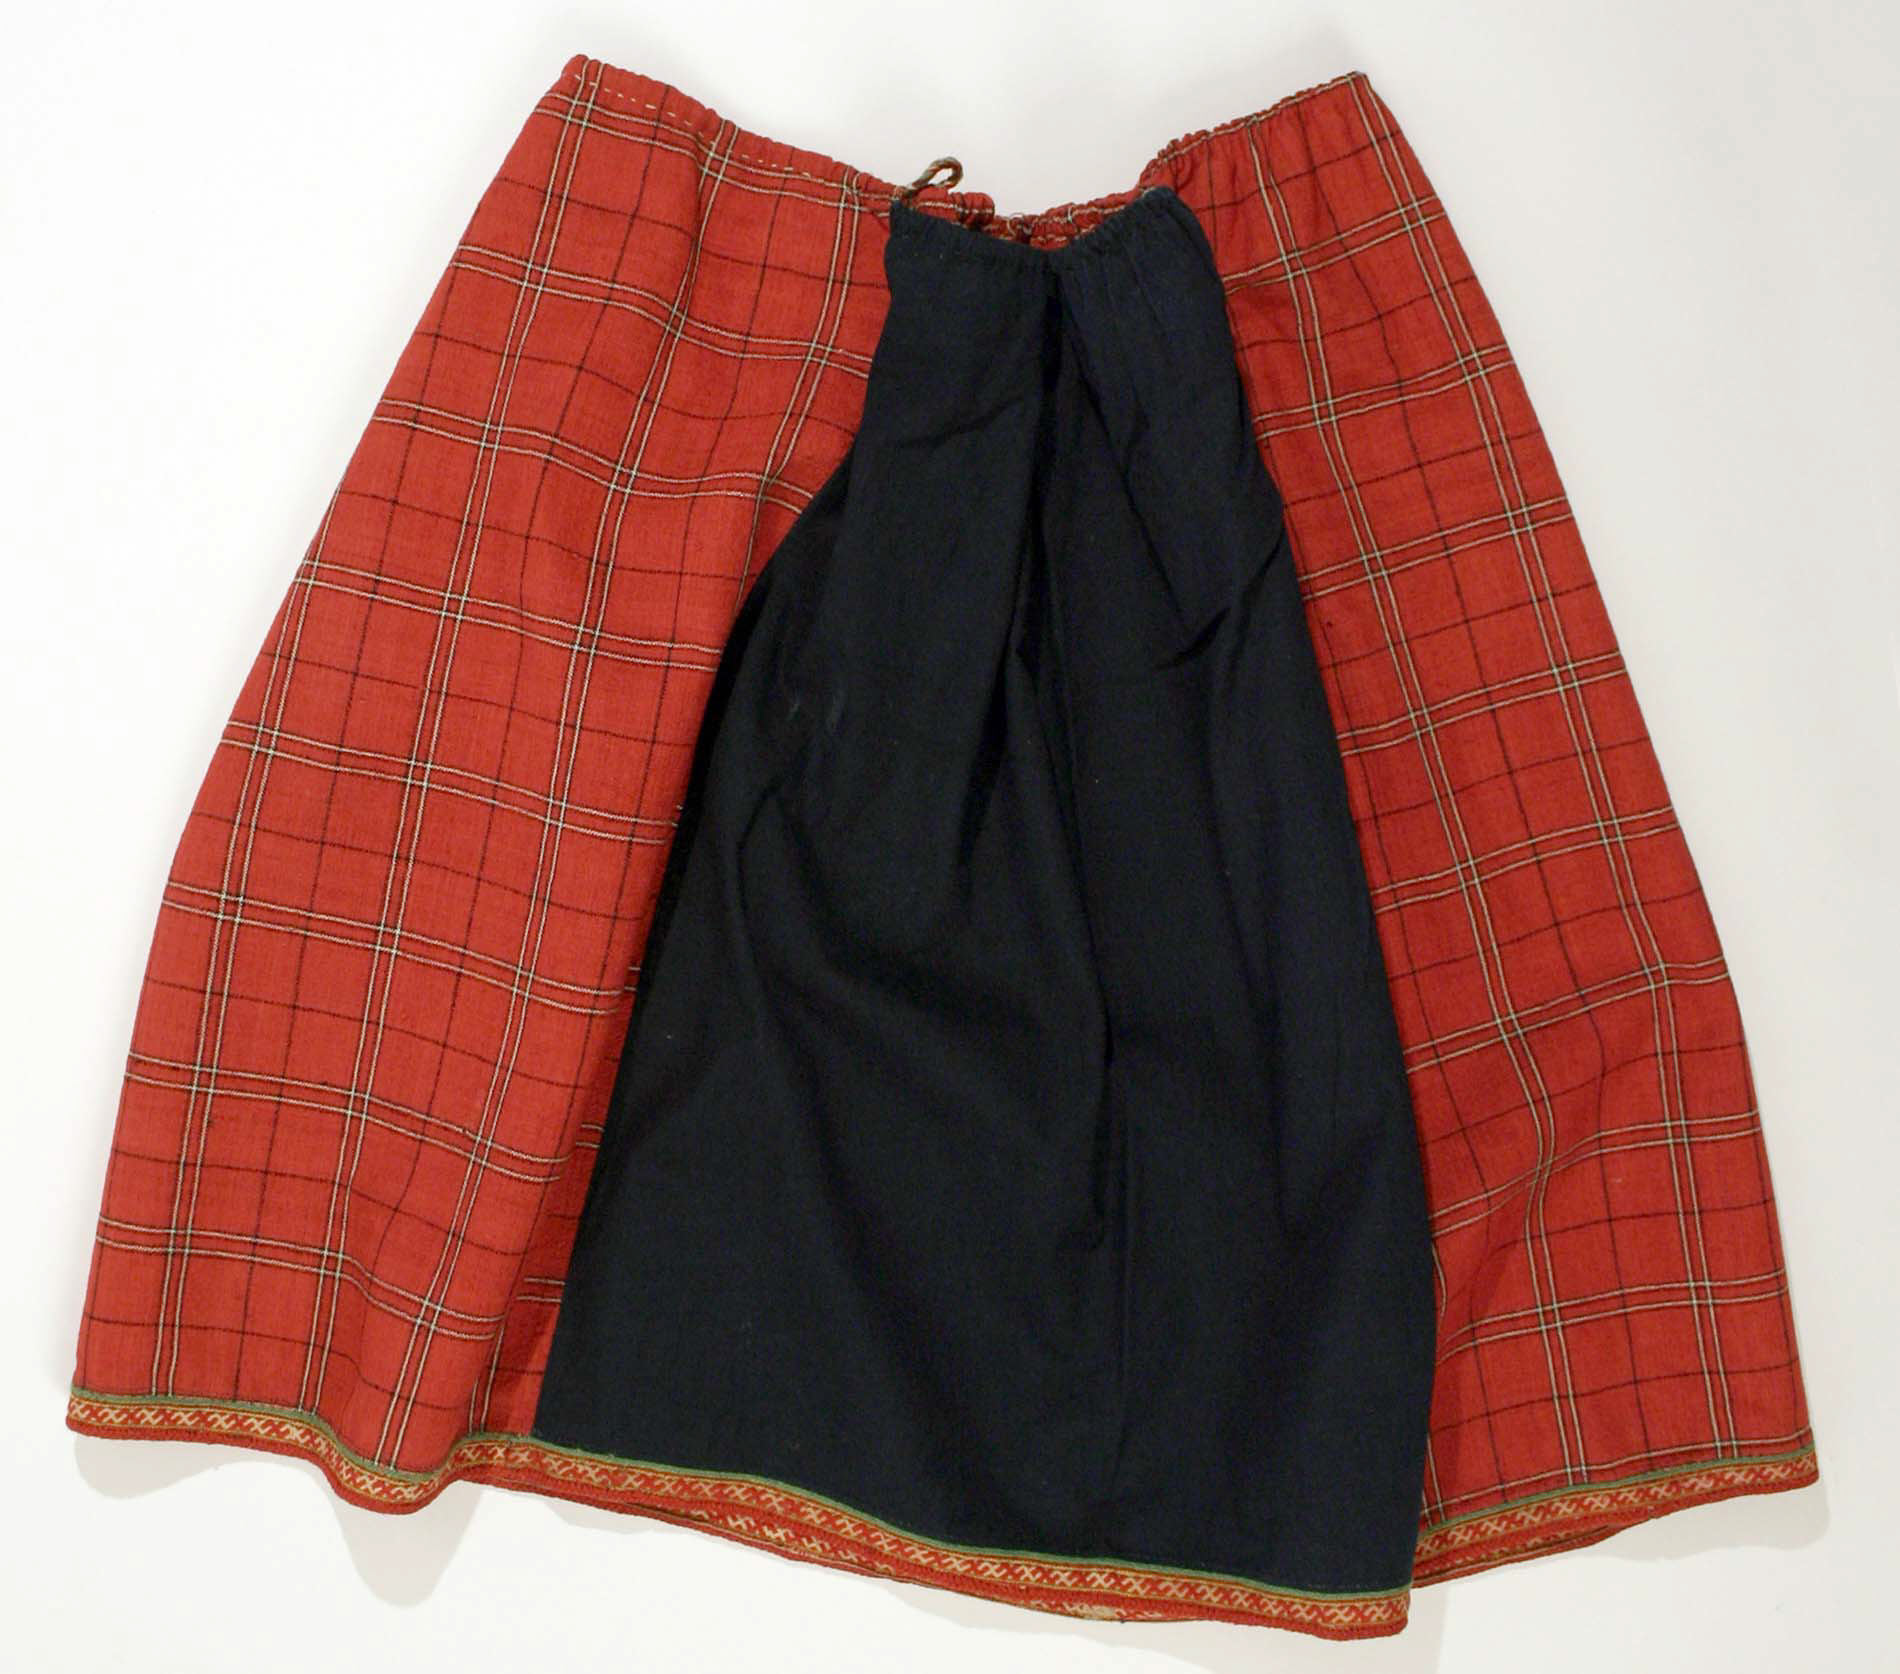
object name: skirt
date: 1801-1900